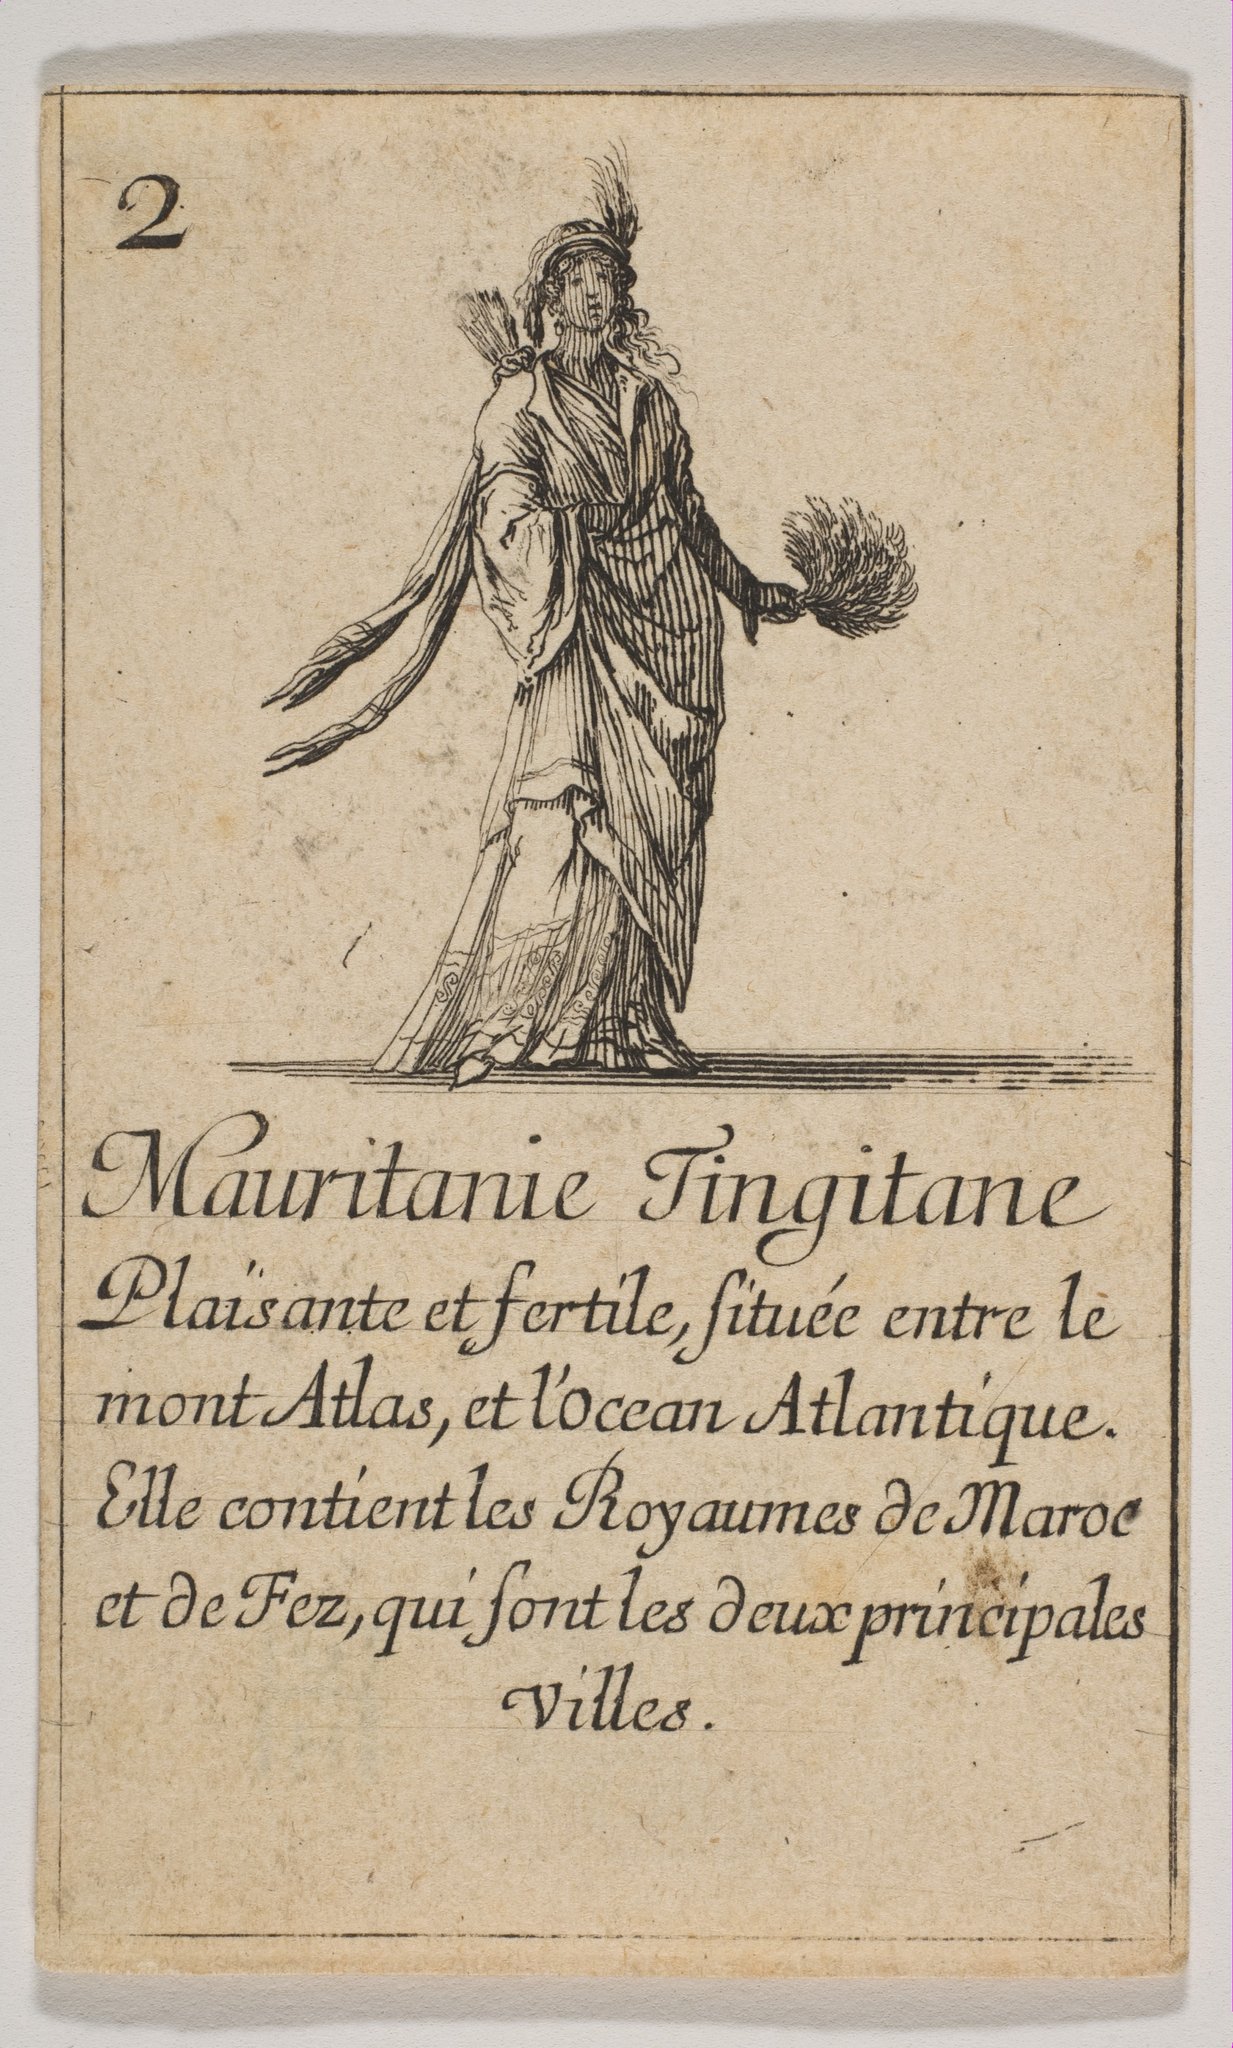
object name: print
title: Mauritanie, from "Jeu de la Géographie"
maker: stefano della bella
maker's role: artist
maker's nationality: italian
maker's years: 1610-1664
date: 1644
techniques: etching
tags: women